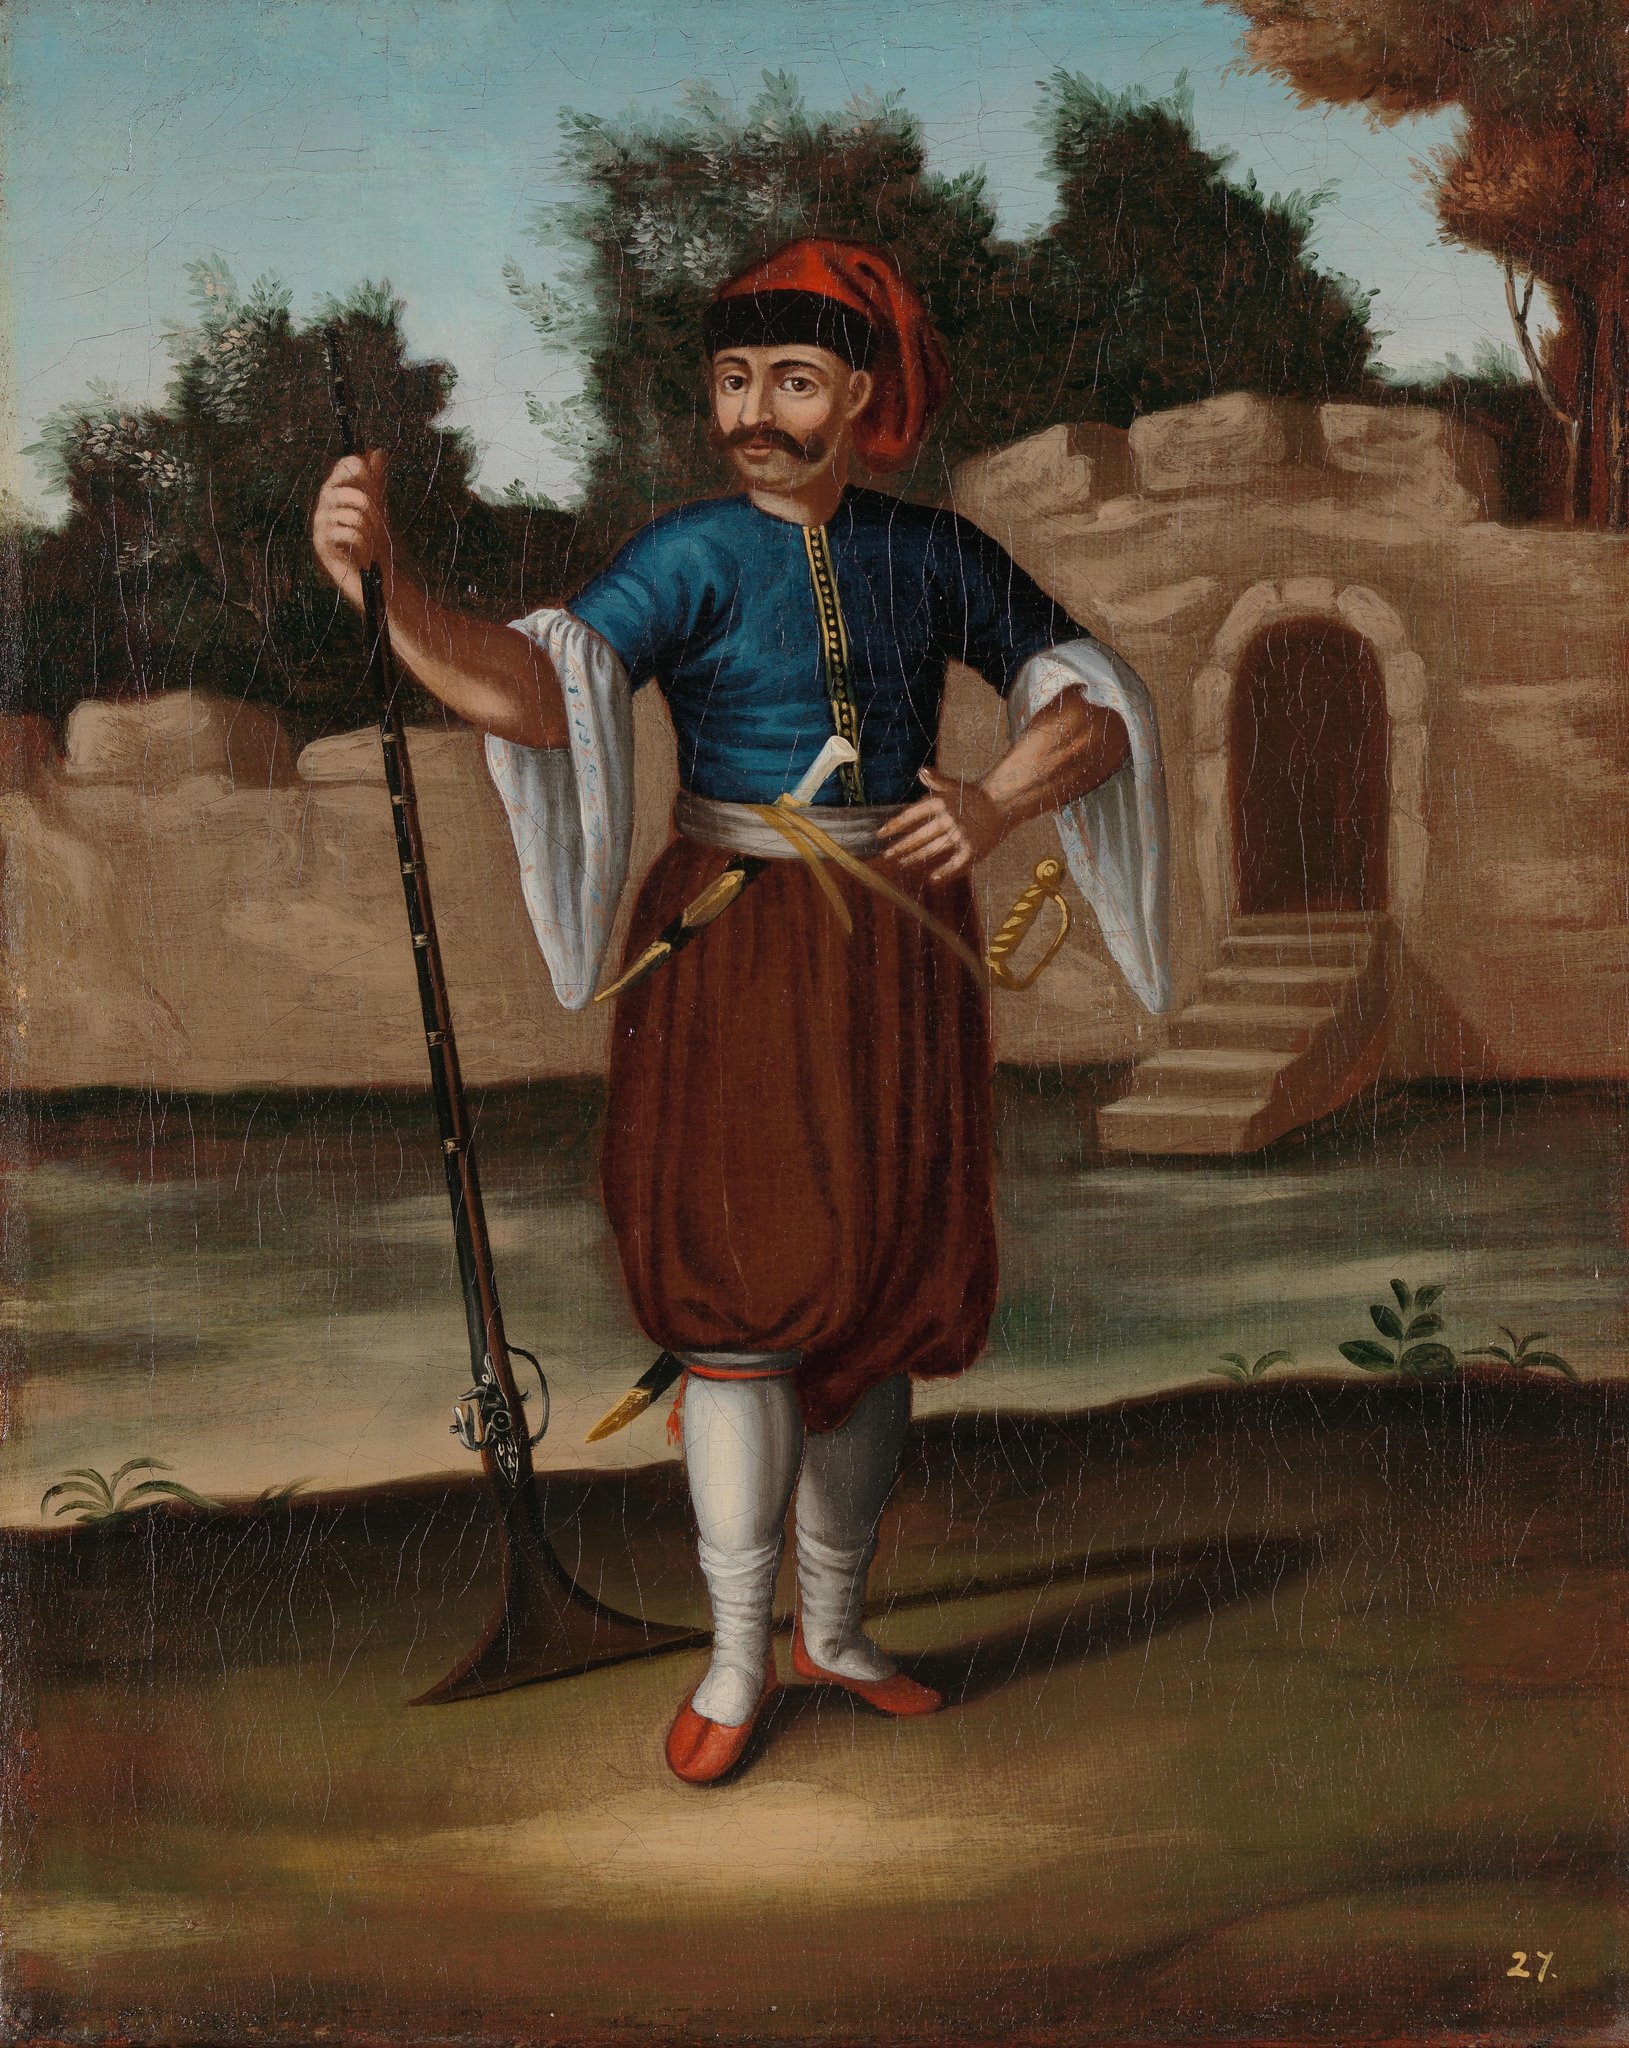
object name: painting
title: Albanian Soldier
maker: jean baptiste vanmour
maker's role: painter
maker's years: 1671-1737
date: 1700-1737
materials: canvas, oil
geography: istanbul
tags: folk costume, regional costume, the soldier; the soldier's life, firearms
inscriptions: inscription: ‘Arbanes / Een Arbanees Soldaat’, number: ‘27’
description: Een Albanese soldaat. Staande, ten voeten uit, voor een stenen muur. De rechterhand op de loop van een geweer.